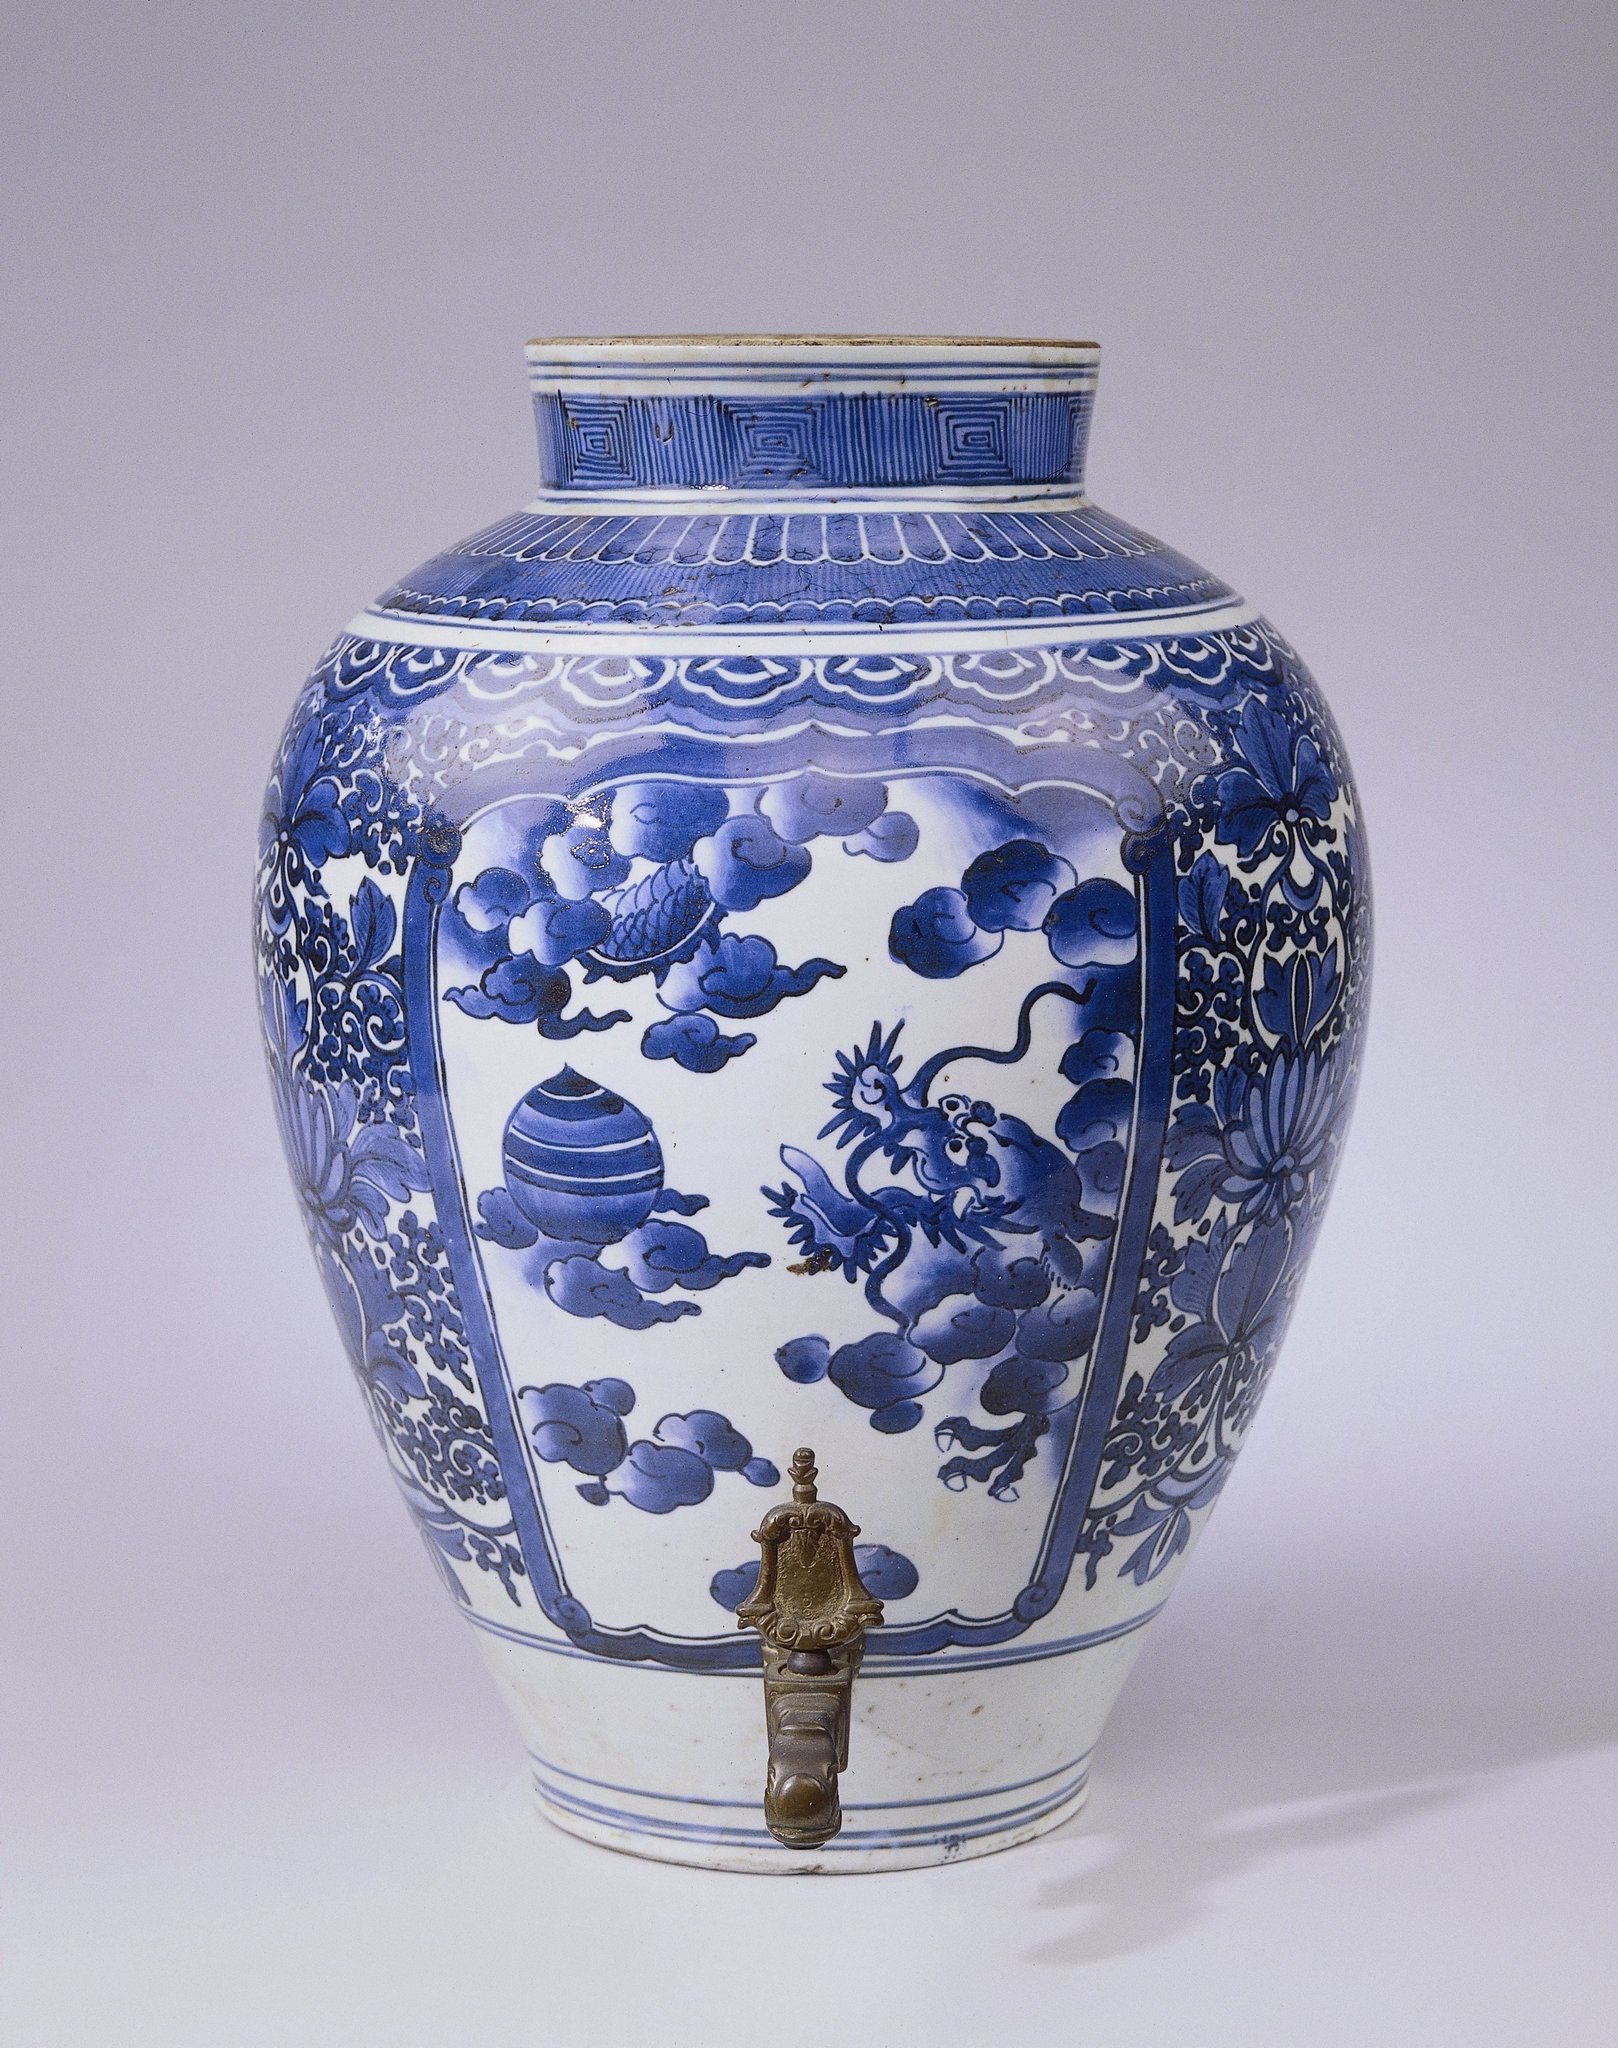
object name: covered jar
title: Ovoid jar (fountain jar) with flowering plants near a rock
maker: Anonymous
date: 1670-1680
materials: brass, cobalt, glaze, paint, porcelain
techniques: firing, turning, vitrification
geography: arita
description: Jar with cover. Japan, Arita. Late 17th century. Porcelain, decoration in underglaze blue.